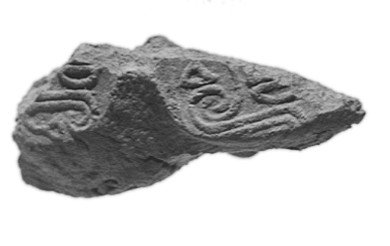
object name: sealing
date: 2030-1640 BCE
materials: clay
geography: egypt